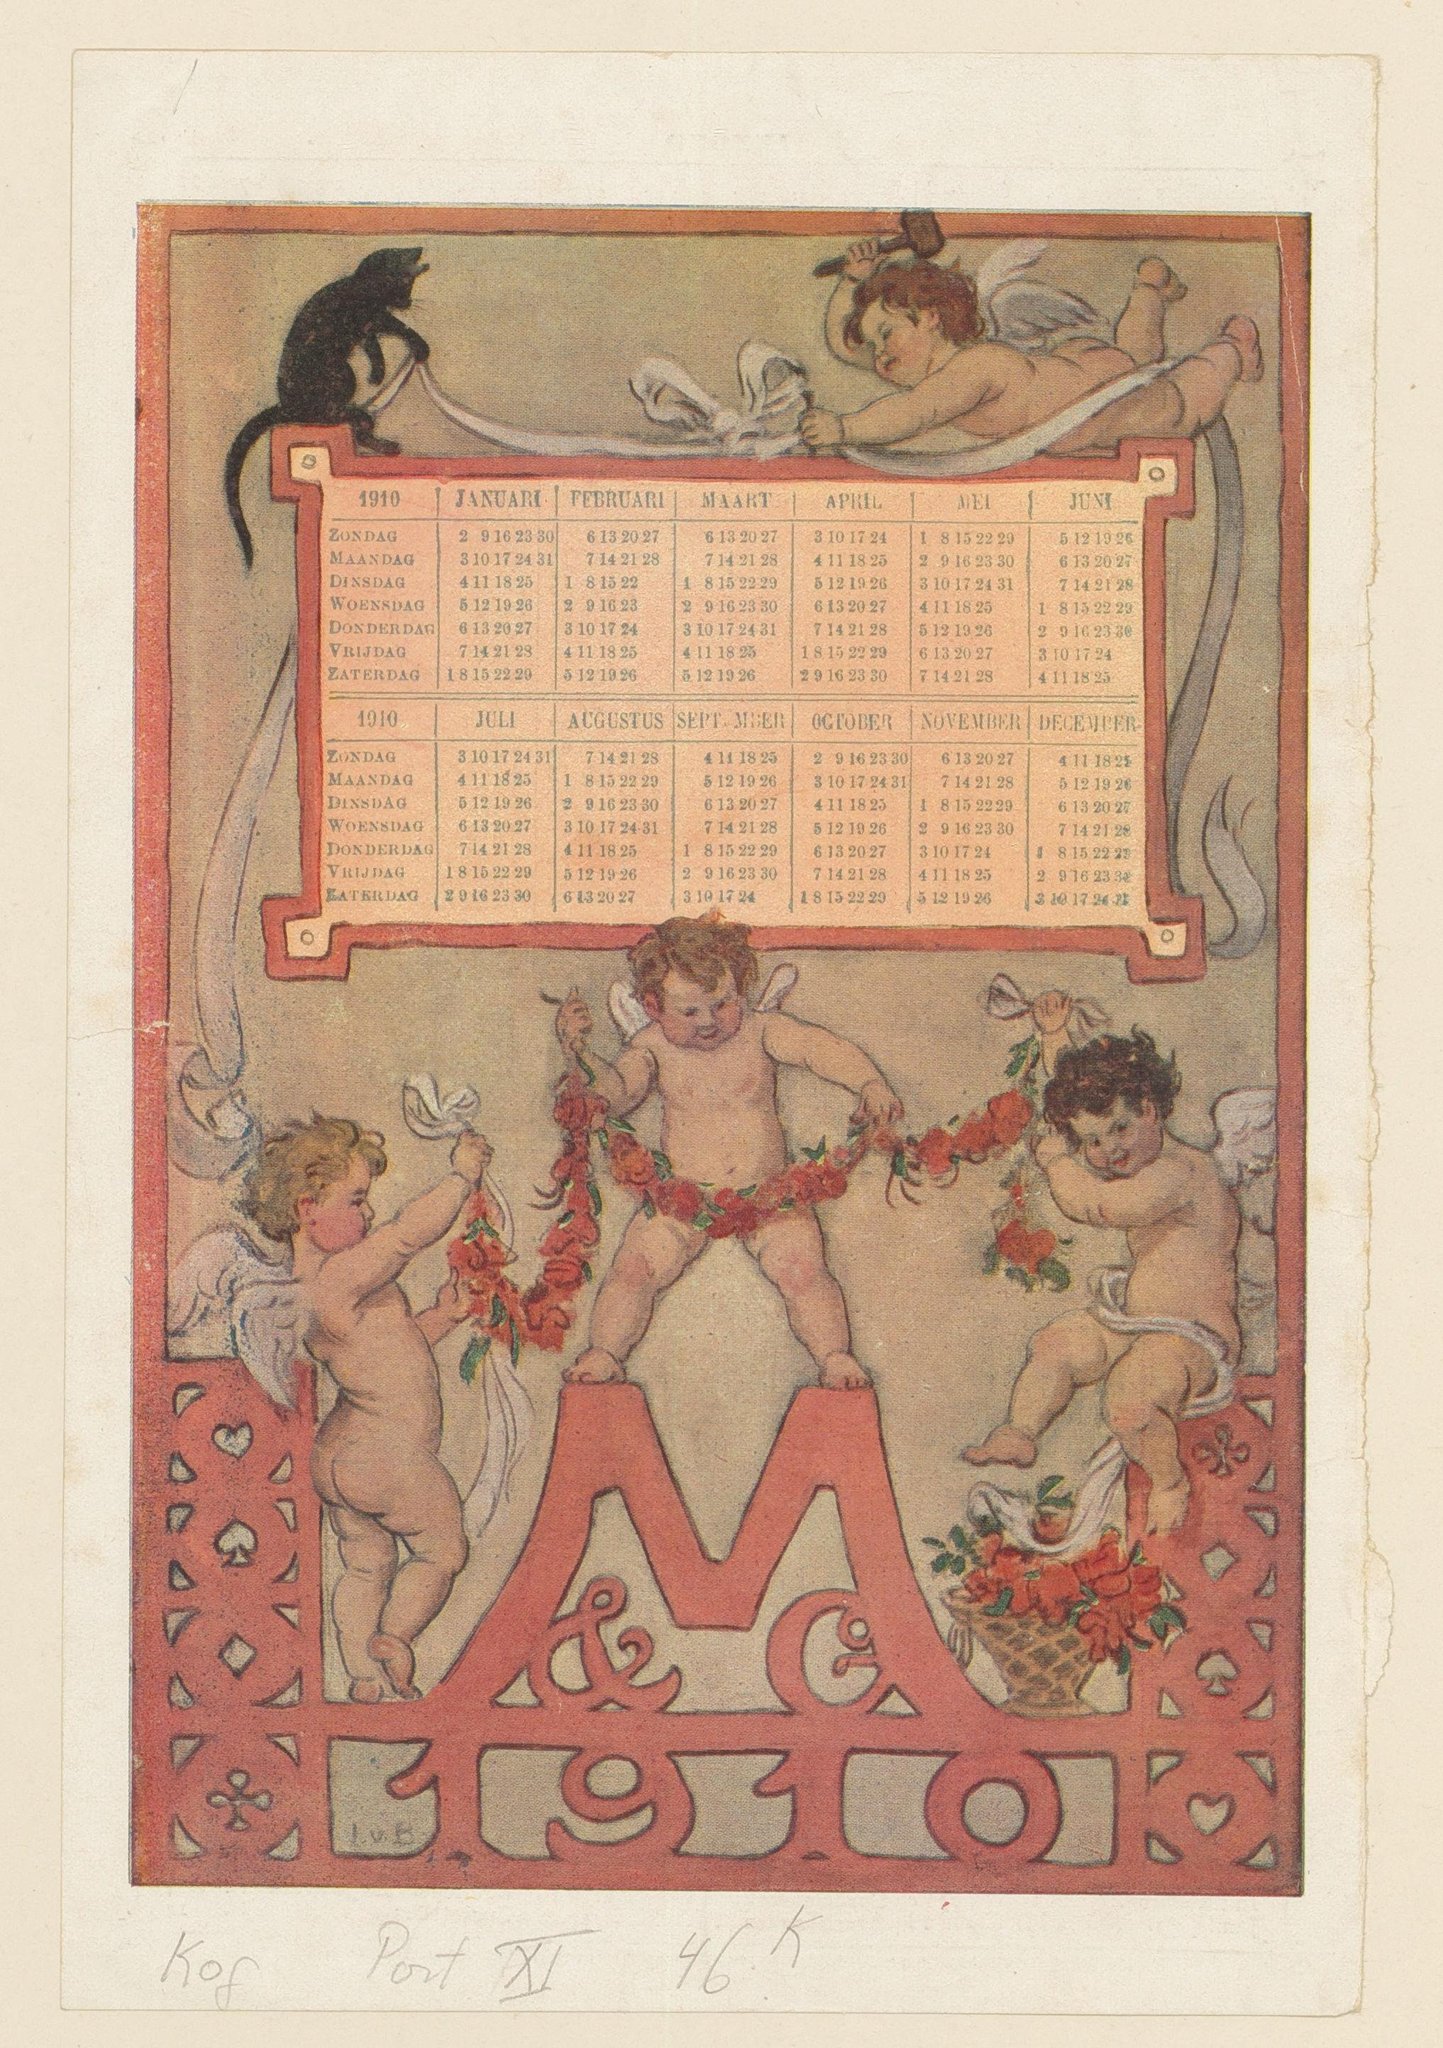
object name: calendar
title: Kalender 1910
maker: Anonymous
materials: paper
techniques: color autotype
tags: cat, cupids: 'amores', 'amoretti', 'putti'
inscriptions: stamp, collector's mark: Lugt 1641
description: Kalender van 1910 versierd met putti die een bloemenslinger vasthouden. Onderaan M&G 1910. Op verso een inhoud van artikelen die het bedrijf M&G verkoopt. Onderwerpsrubrieken binnen de Atlas Zeden en Gewoonten: Handel, nijverheid en verkeer, Koophandel, Veilingen, Makelaardij en Verzekeringswezen, Oude adreskaarten van winkels en fabrieken, reclame.